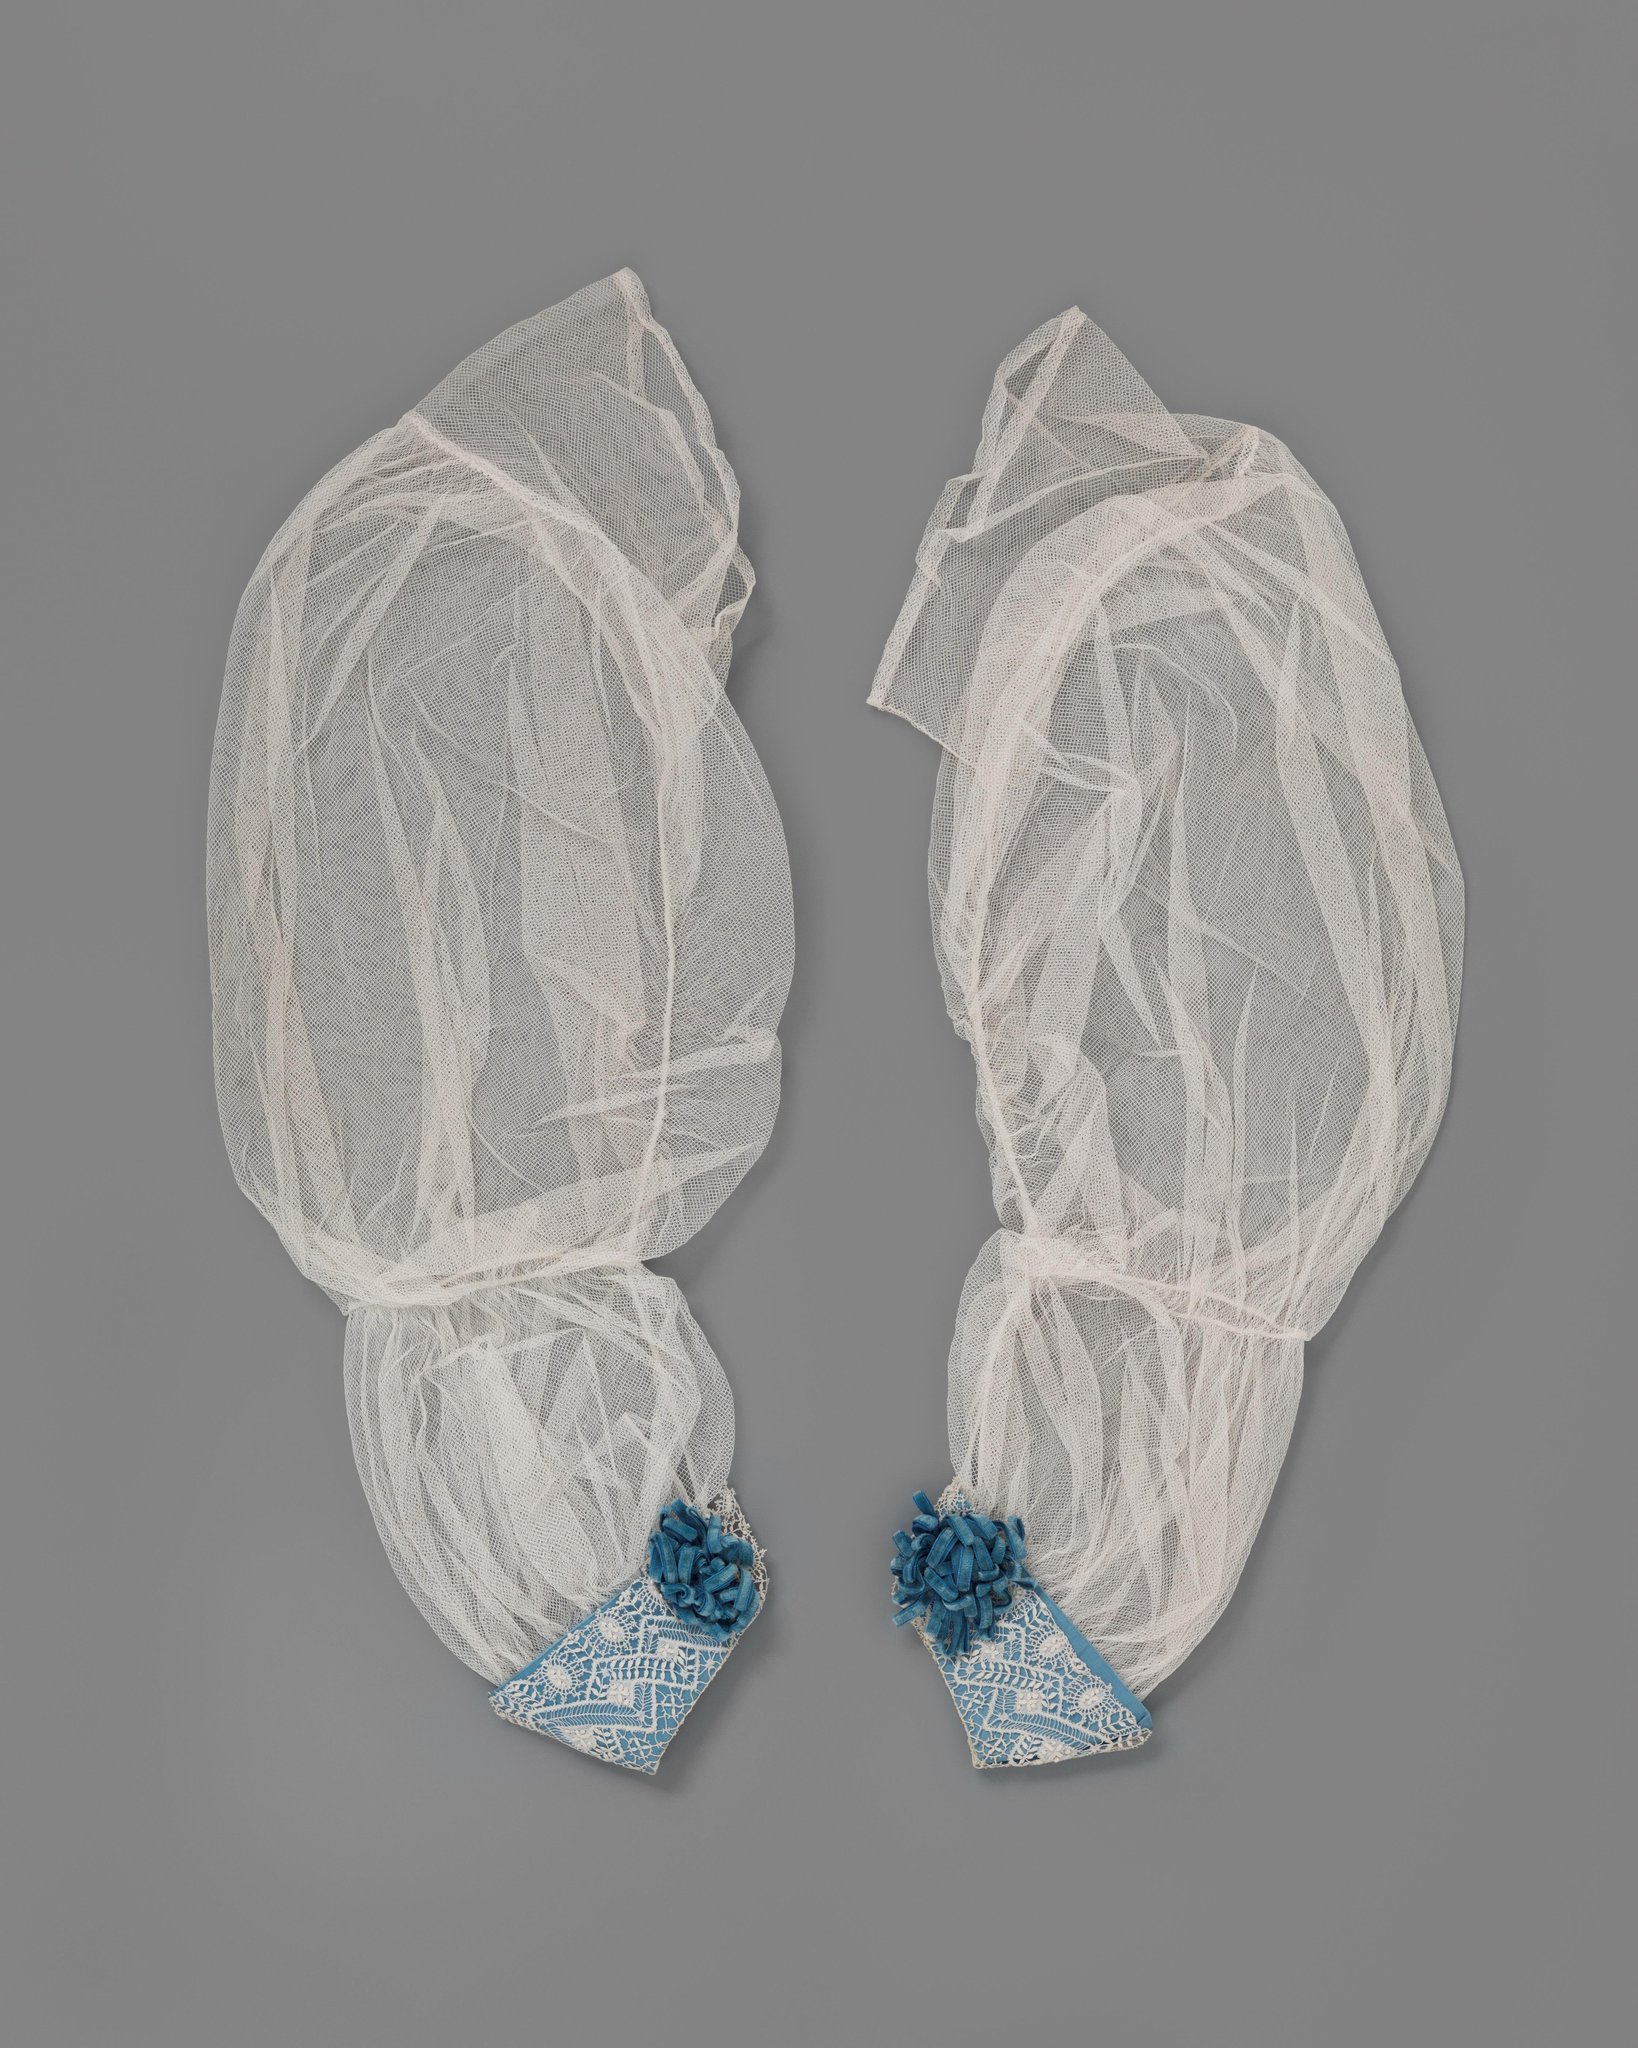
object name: womenswear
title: Ondermouw van machinale tule met manchet van Clunykant en versierd met blauw lint en fluweel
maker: Anonymous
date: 1860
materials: mother of pearl, ribbon, velvet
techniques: lace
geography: france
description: Ondermouw van machinale tule met manchet van Cluny kloskant en versierd met blauw lint en fluweeltje. Model. Ballonmouw, die halvewege eenmaal is ingesnoerd. Glad, puntig, omslagmanchetje van kant, met blauw ripslint onderlegd, en met een pompoen van blauwe fluwelen lintjes bovenop. Kant. Type Cluny met reliëfblaadjes, linnenslag en een fond van spijlen.